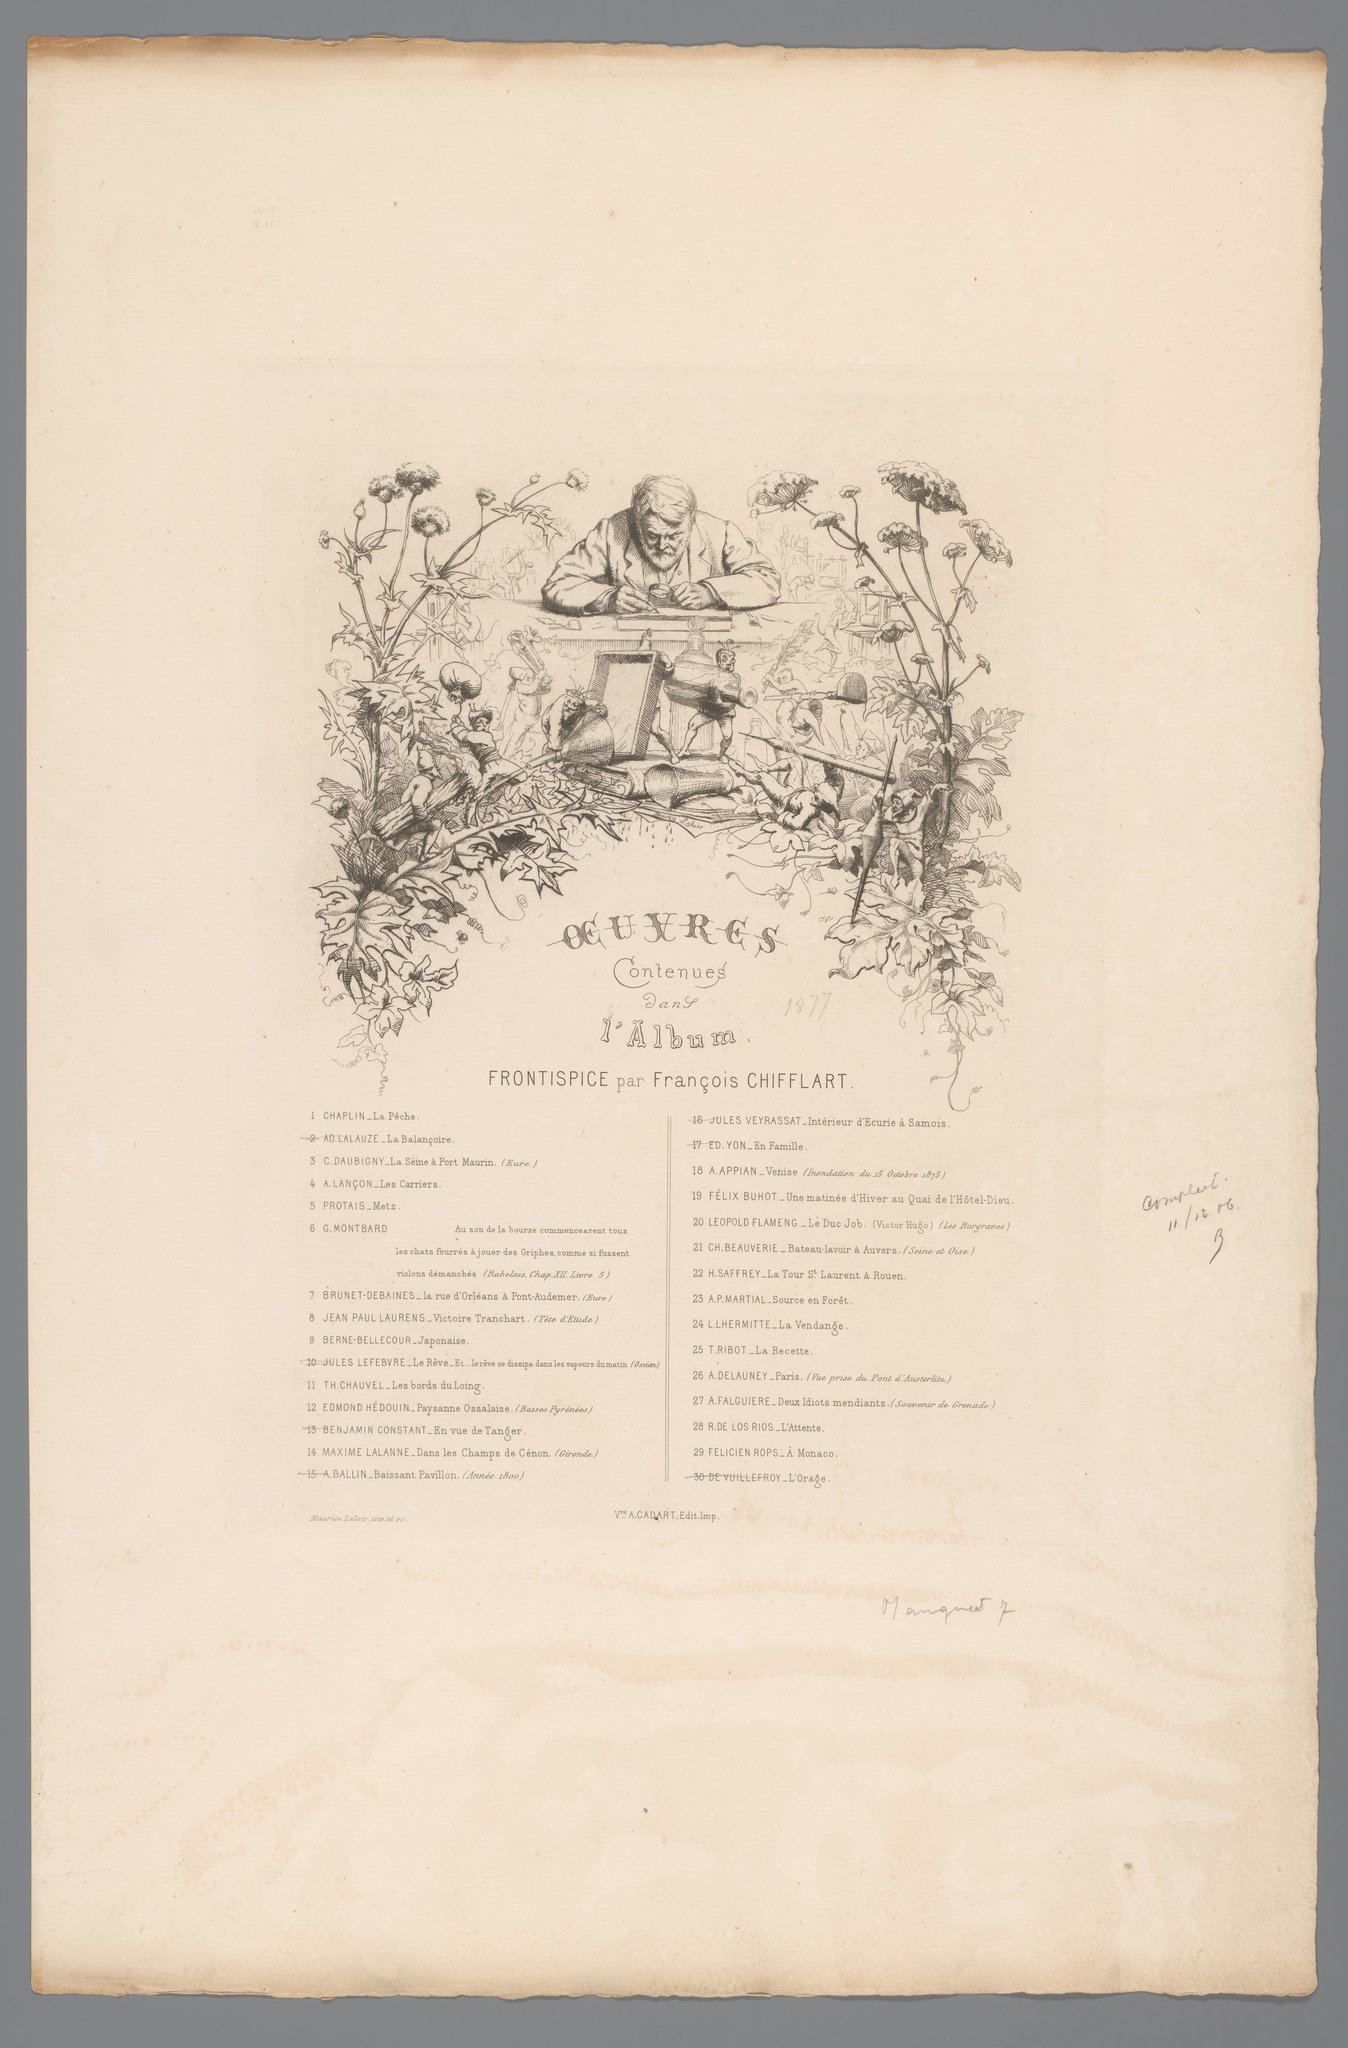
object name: print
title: Etser aan het werk omringd door fantasiewezens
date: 1877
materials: paper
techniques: drypoint, etching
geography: paris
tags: spirit of the earth, gnome, troll, portrait, self-portrait of graphic artist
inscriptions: collector's mark: ‘AFE v S’, collector's mark: Lugt 2228, collector's mark: Lugt 2760